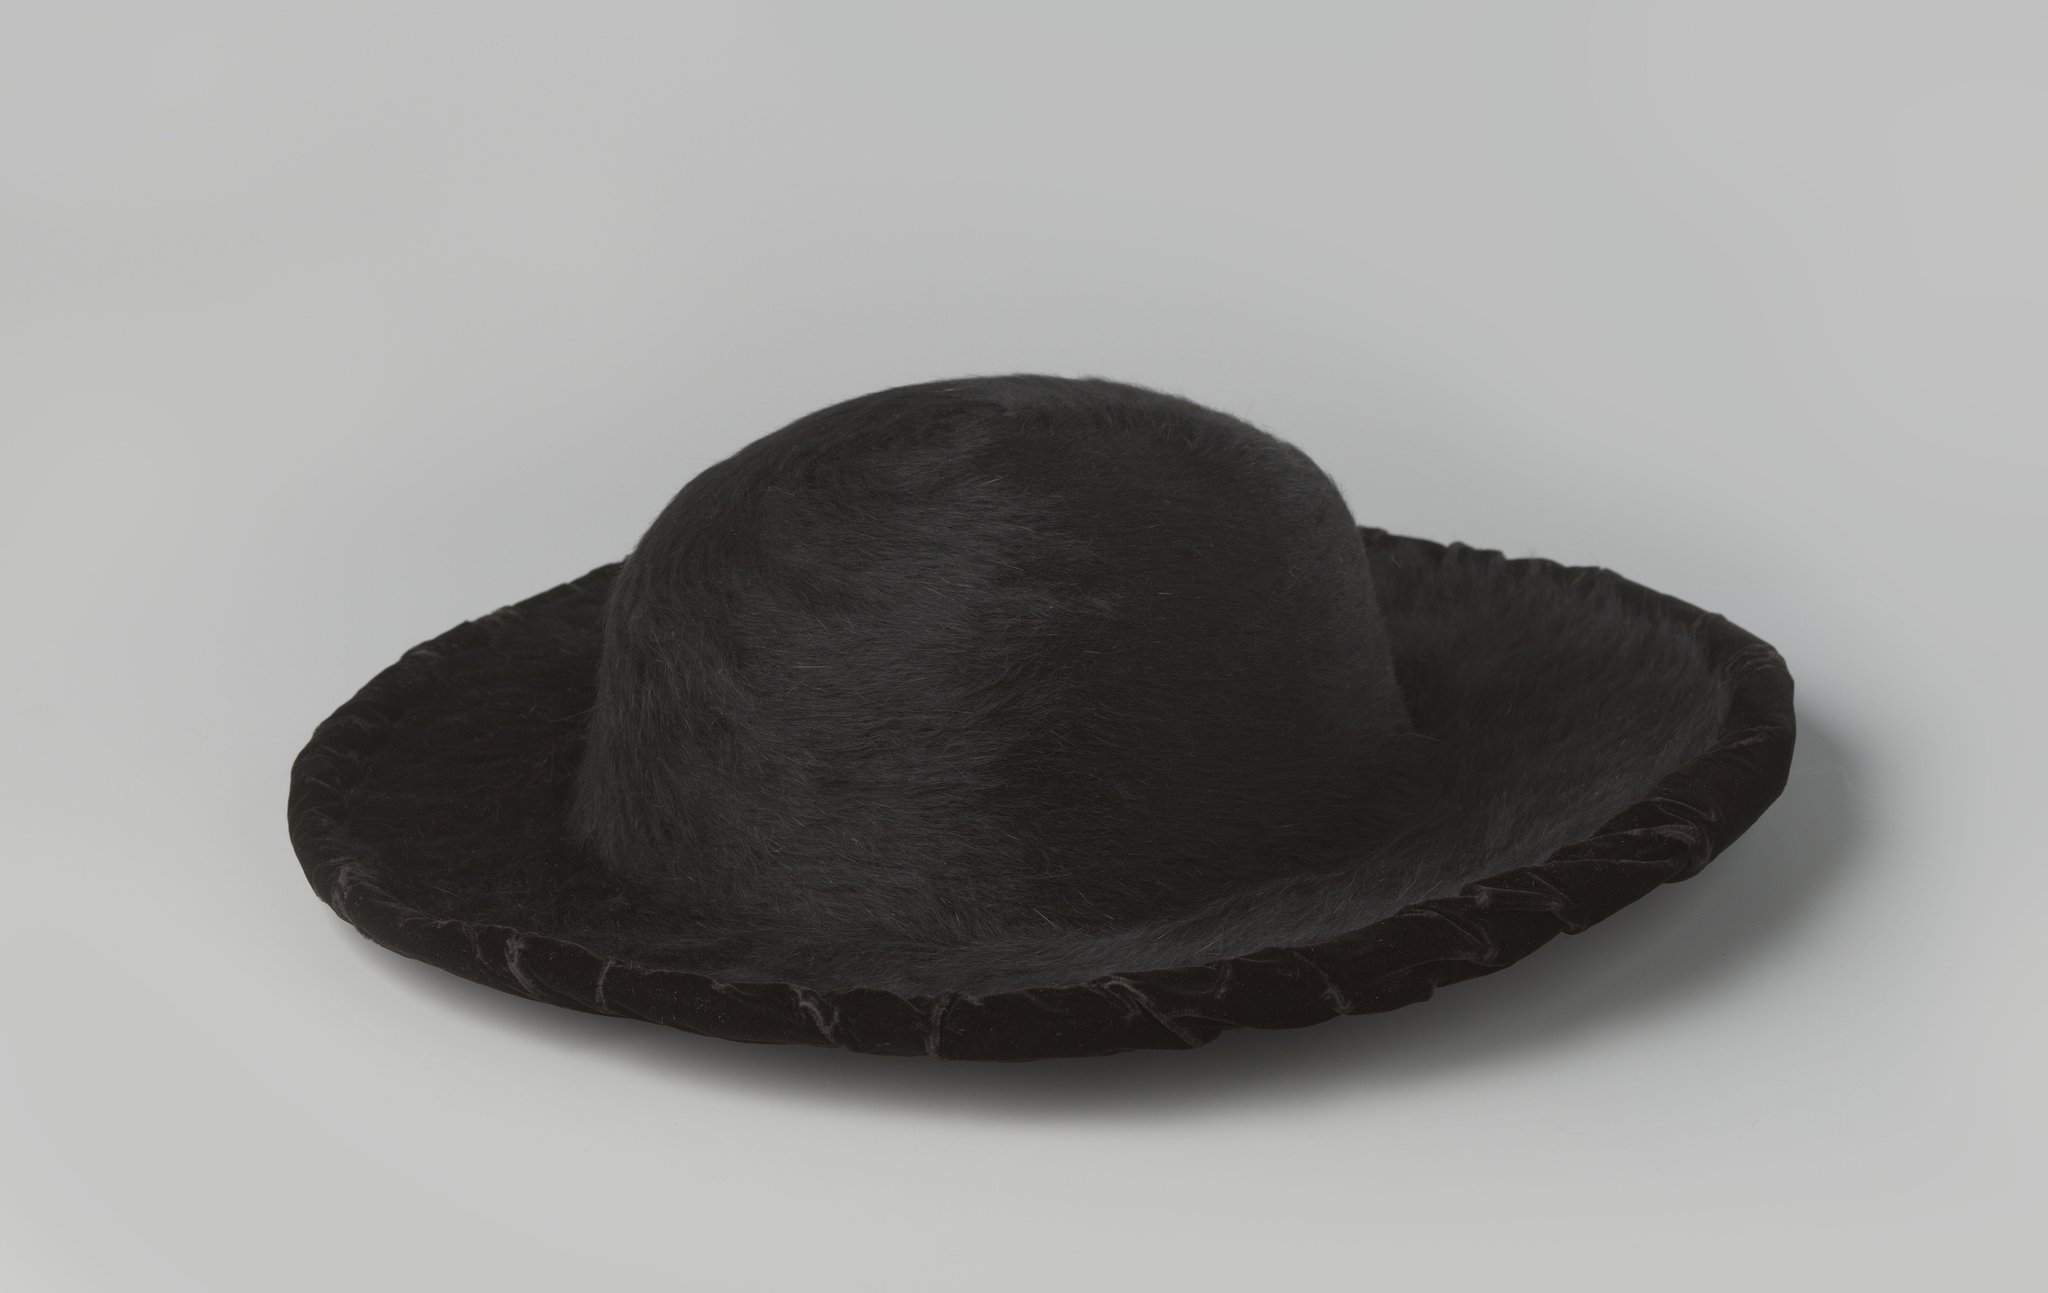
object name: hat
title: Dameshoed met bol van zwart haarvilt en rand van dito vilt en zwart fluweel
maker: a. jacot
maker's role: hoedenmaakster, modiste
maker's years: 1869-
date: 1898-1905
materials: textile, velvet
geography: amsterdam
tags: amsterdam, hieronyma maria anthonia fortunata six-bosch reitz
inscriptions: signature: ‘A. Jacot’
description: Naar alle waarschijnlijkheid is de hoed gedragen door mevrouw Six-Bosch Reitz, die blijkens haar kasboeken vaste klant bij Jacot was. Kasboek H.M.A.F. Six 1902-1908: '1903: 17 febr. Jacot rouwhoed fl. 18,-', '1903: 17 febr. Jacot winterhoed fl. 36,-', ' 1906: 7 maart Jacot rouw fl. 34,55', Collectie Six, Amsterdam, inv. 51894.